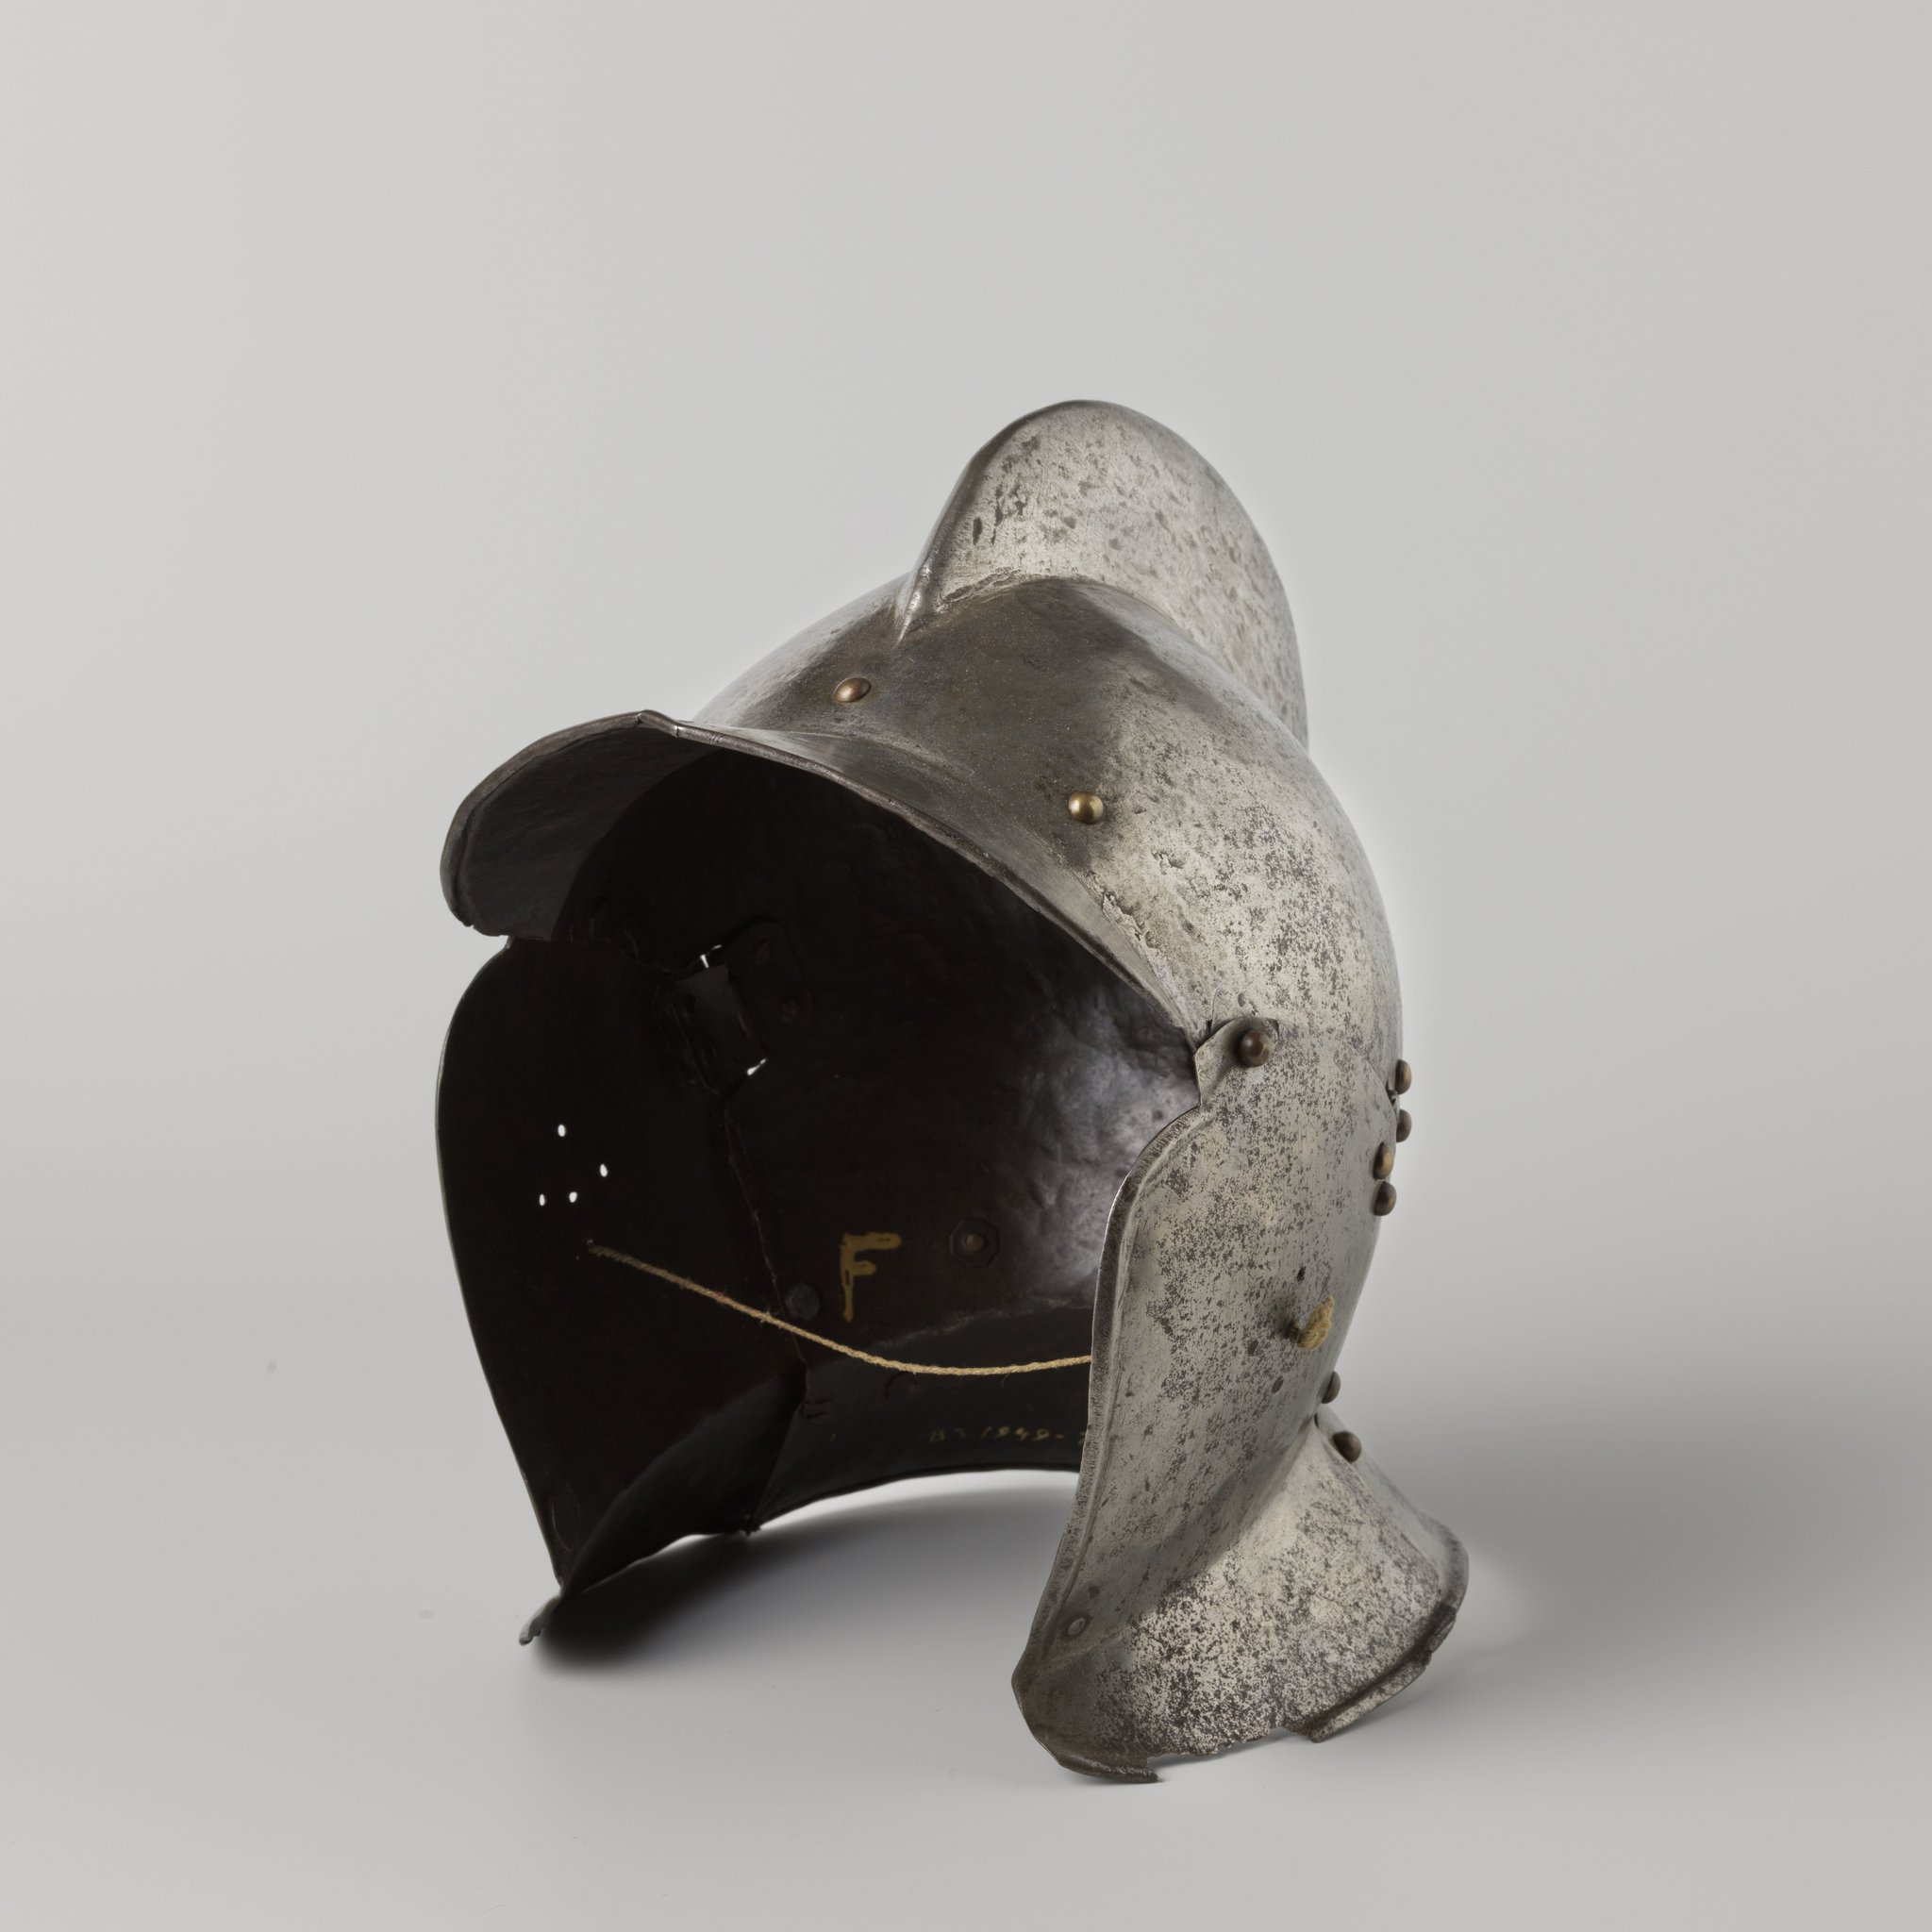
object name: stormhoed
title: Bourgondische stormhoed met korte kam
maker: Anonymous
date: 1600-1699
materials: copper, iron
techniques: forging, riveted, striking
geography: north europe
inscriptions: number: ‘10897 F’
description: Bourgondische stormhoed, ijzer, blank, helmbol met klep en kam van één plaat gemaakt. De klep heeft een punt, op de helmbol een vrij hoge kam. Aangeklonken nekplaat. Scharnierende wangplaten met luchtgaatjes aangeklonken met koperen klinknagels. De randen zijn geflenst. De binnenkant van de helm is zwart, er is een groen overblijfsel van vermoedelijk verf zichtbaar. Een touw tussen de wangkleppen houden deze op hun plaats.